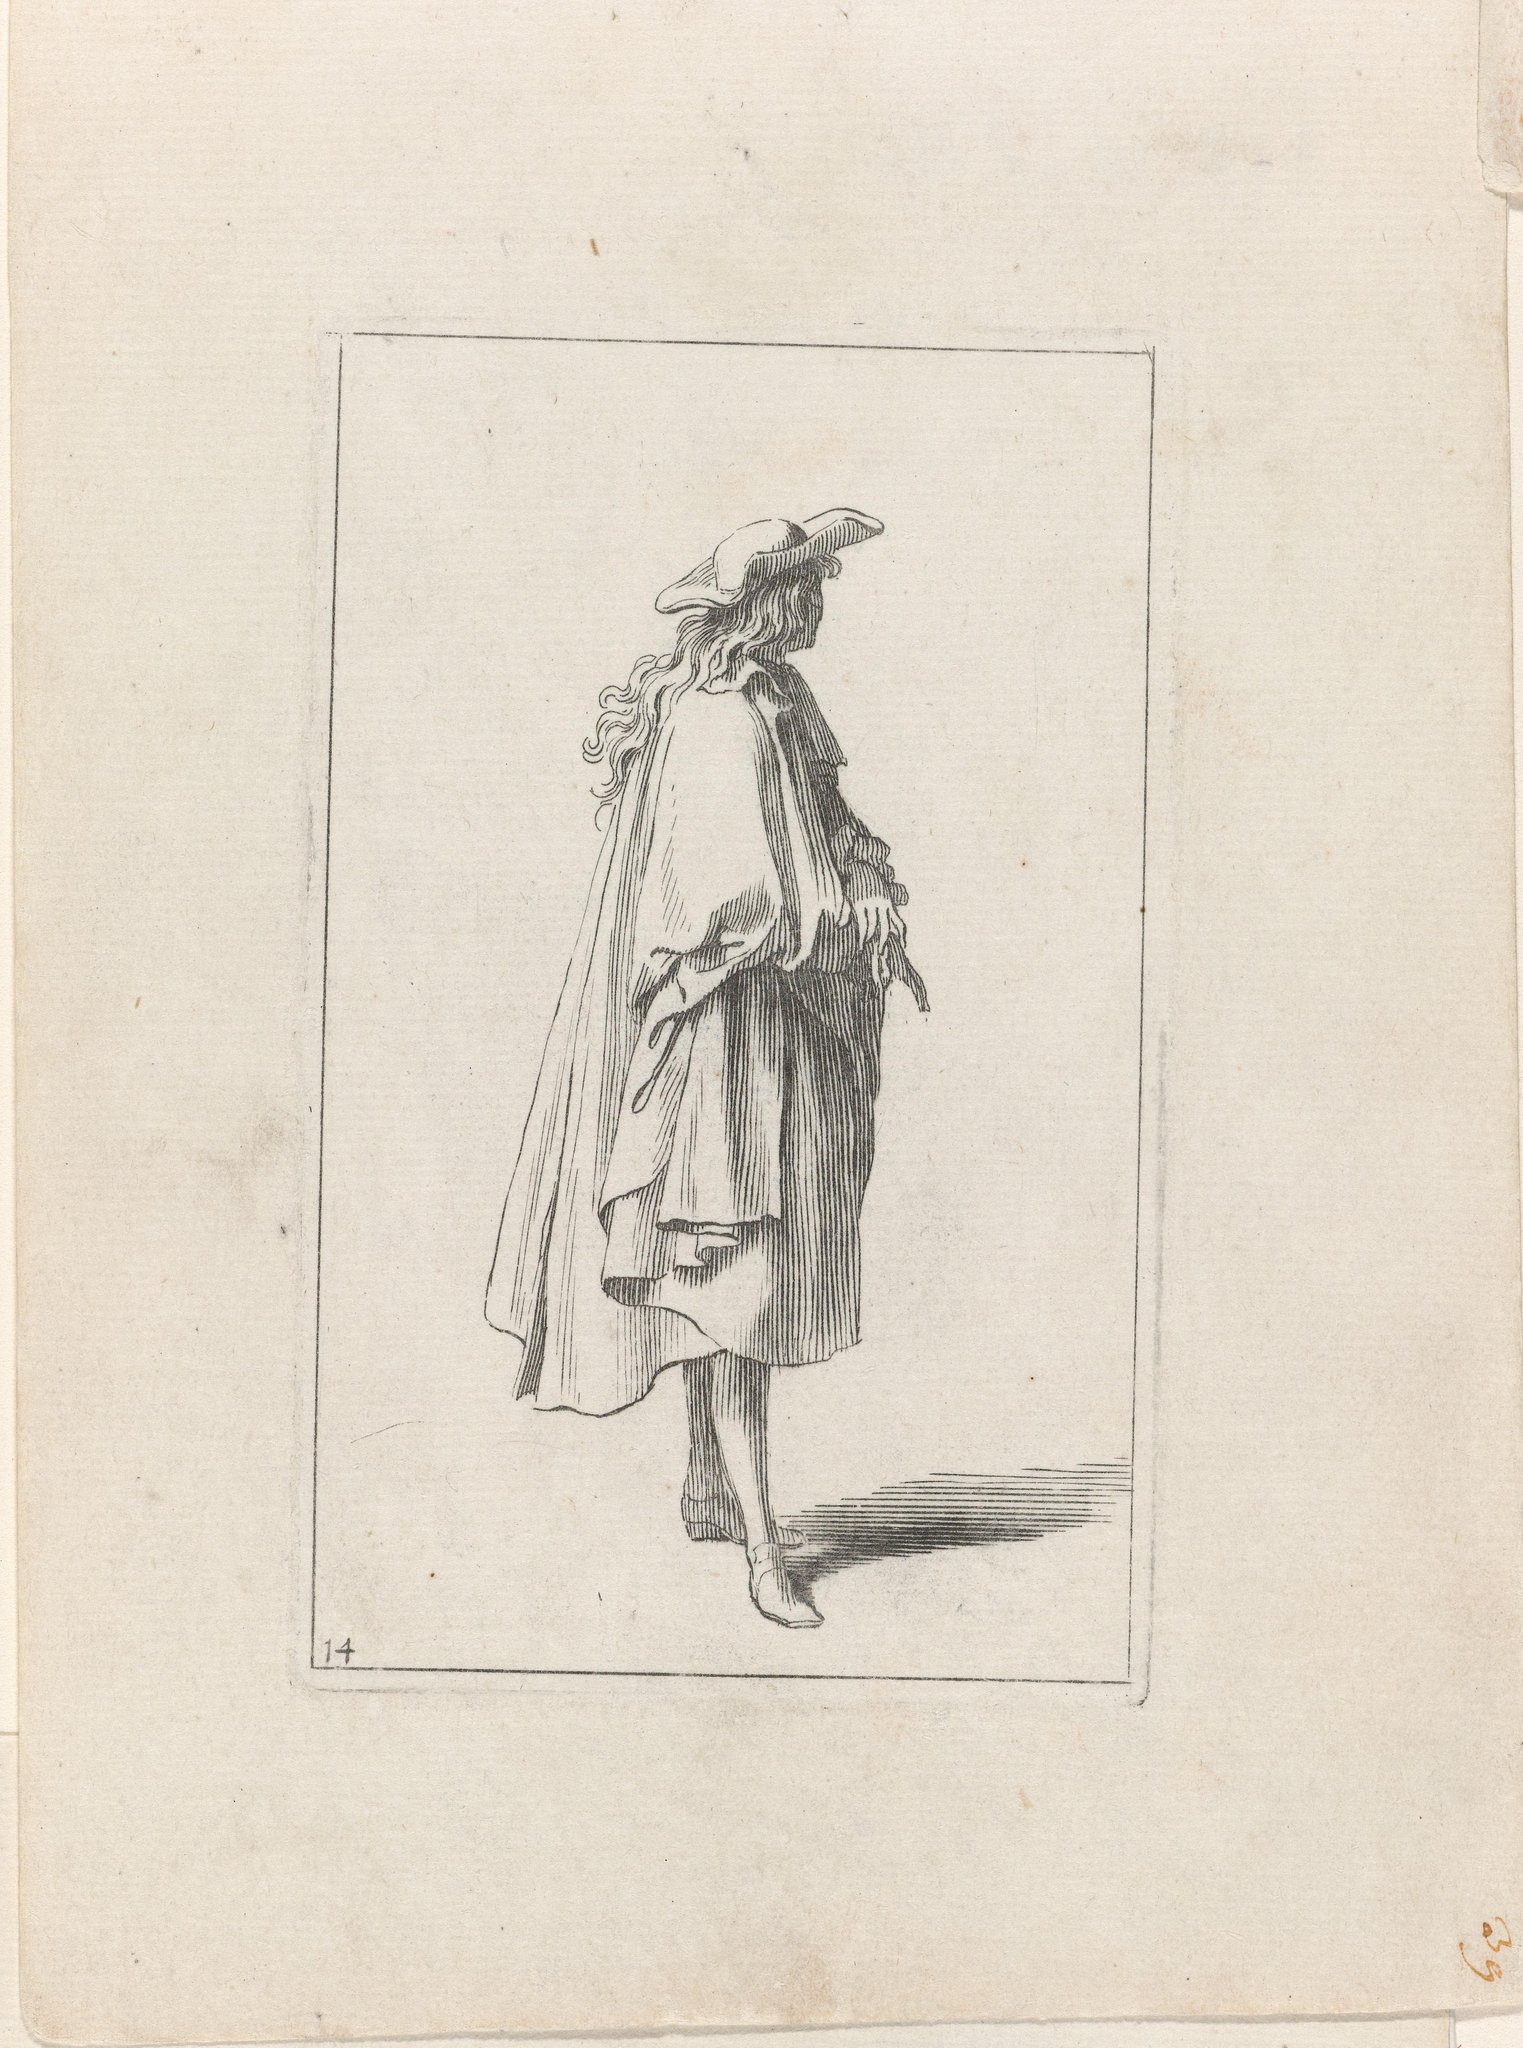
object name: print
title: Man in losse schoudercape, hoed op de lange haren, naar rechts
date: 1685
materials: paper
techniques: etching